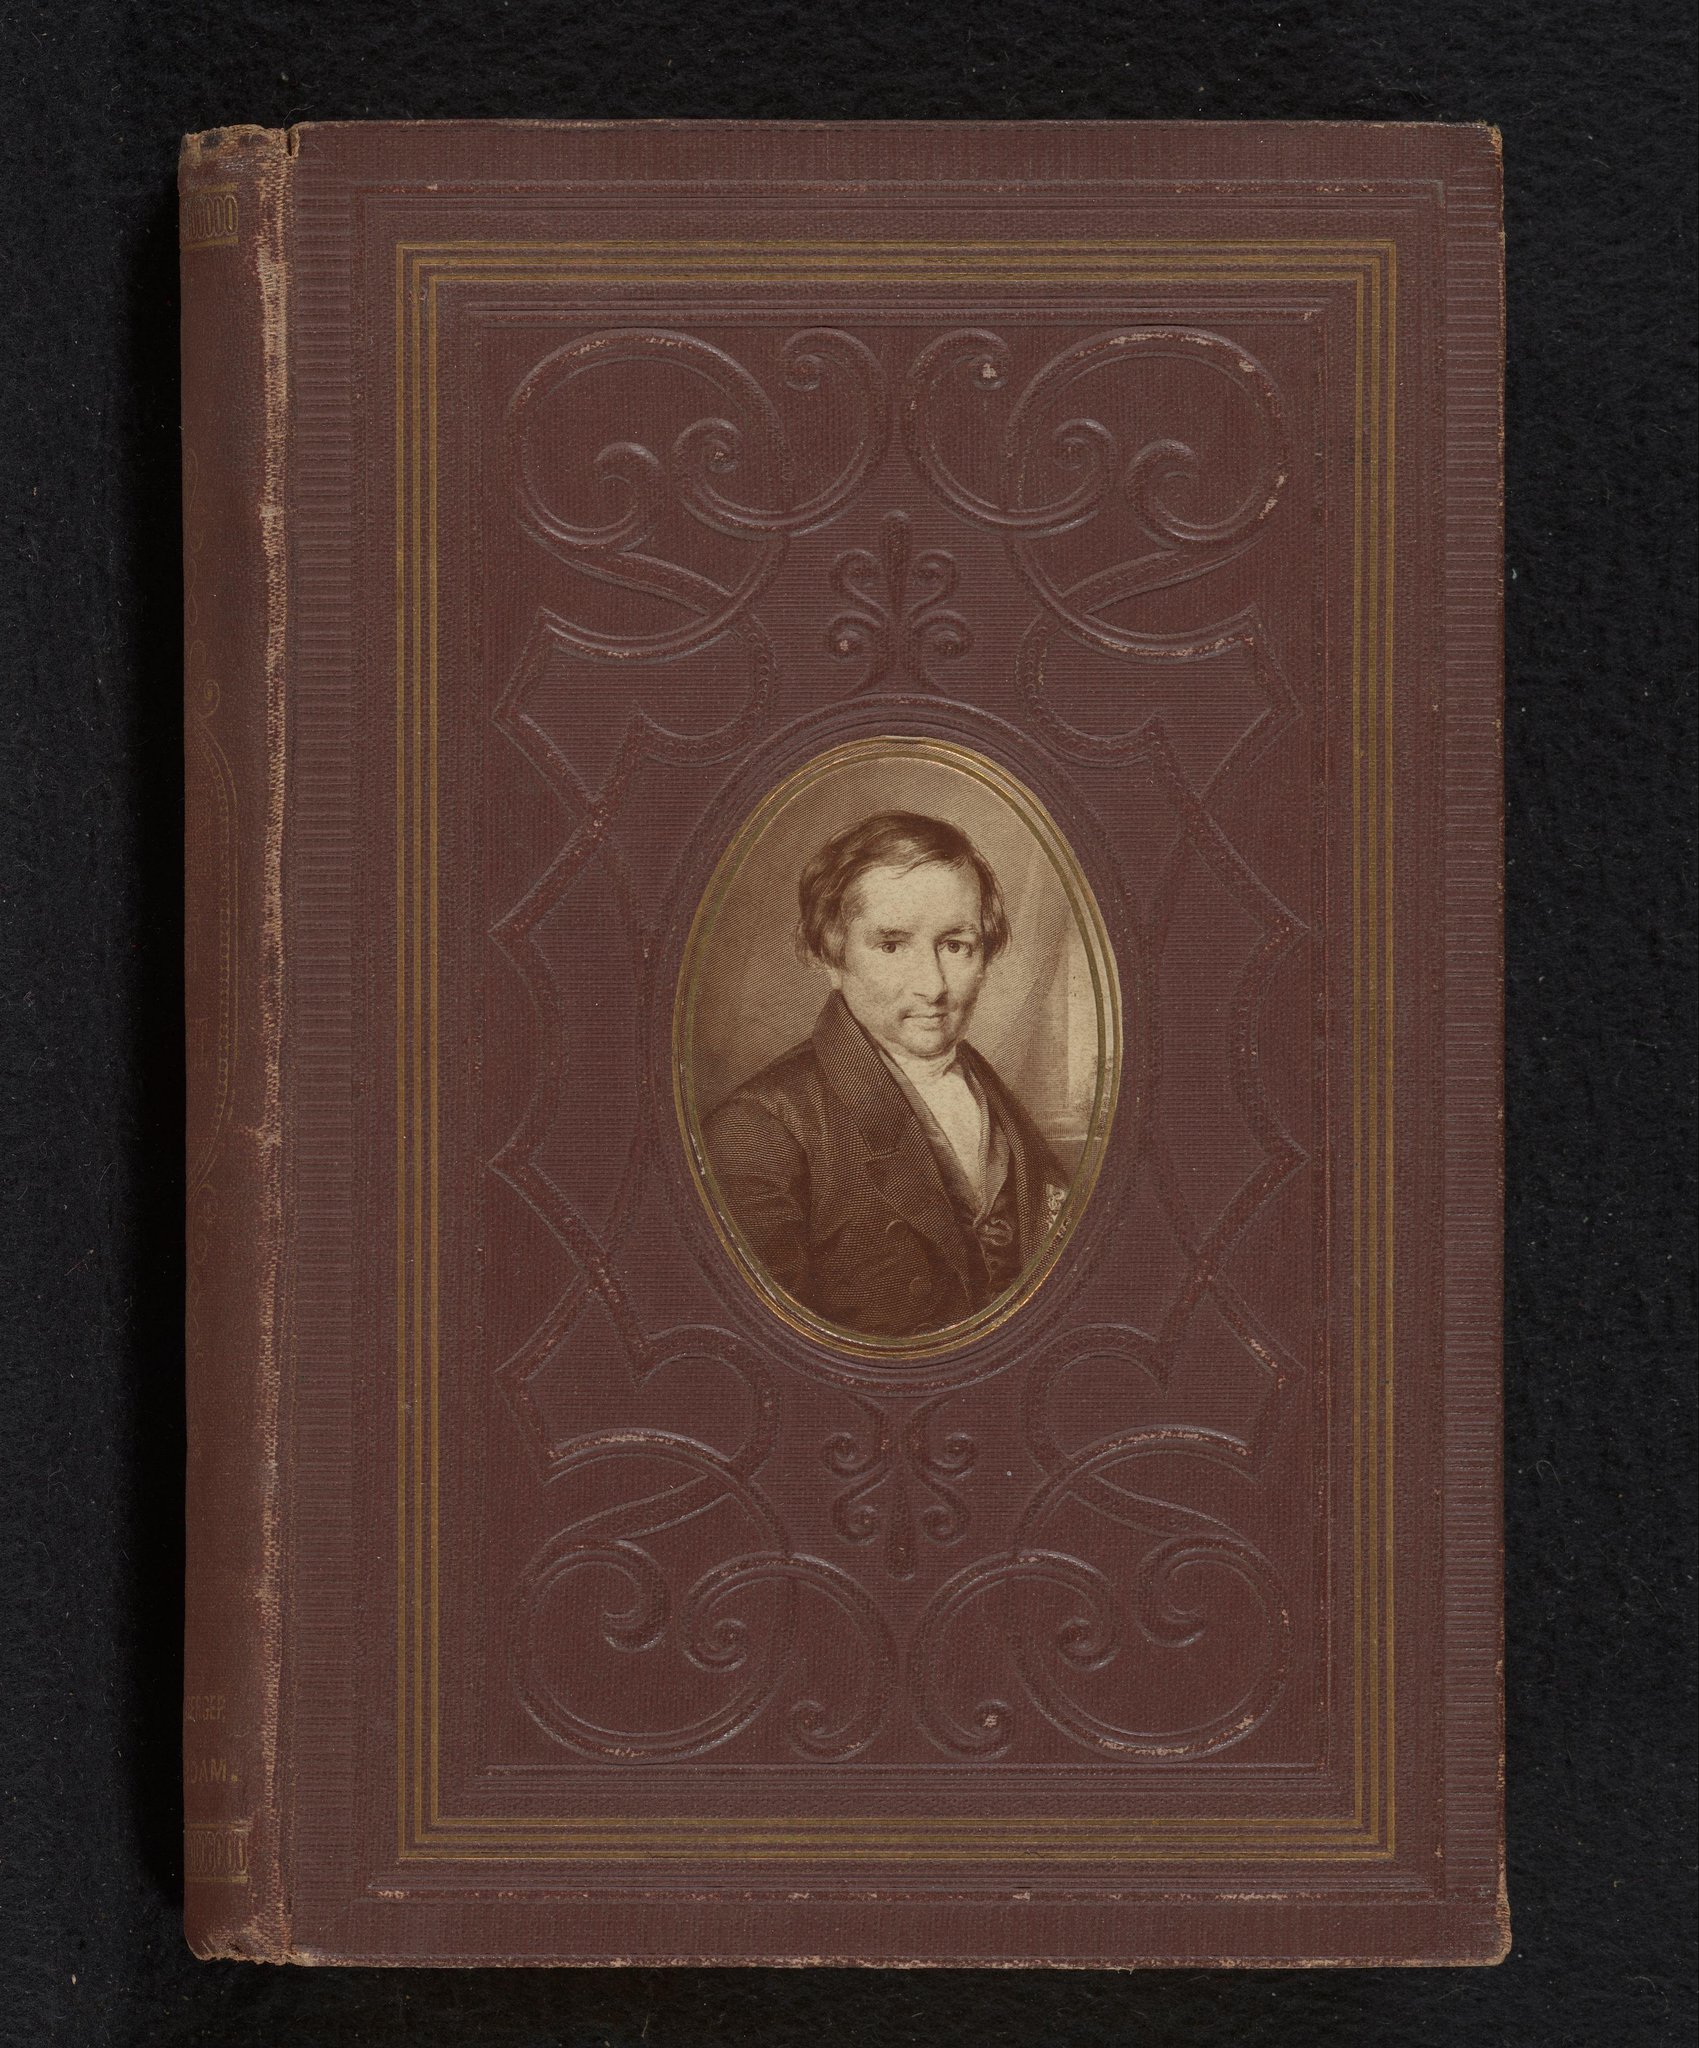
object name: page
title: Fotoreproductie van een gravure van een portret van Johannes Petrus Hasebroek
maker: Anonymous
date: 1869-1874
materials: paper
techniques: albumen print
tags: leiden, amsterdam, historical persons